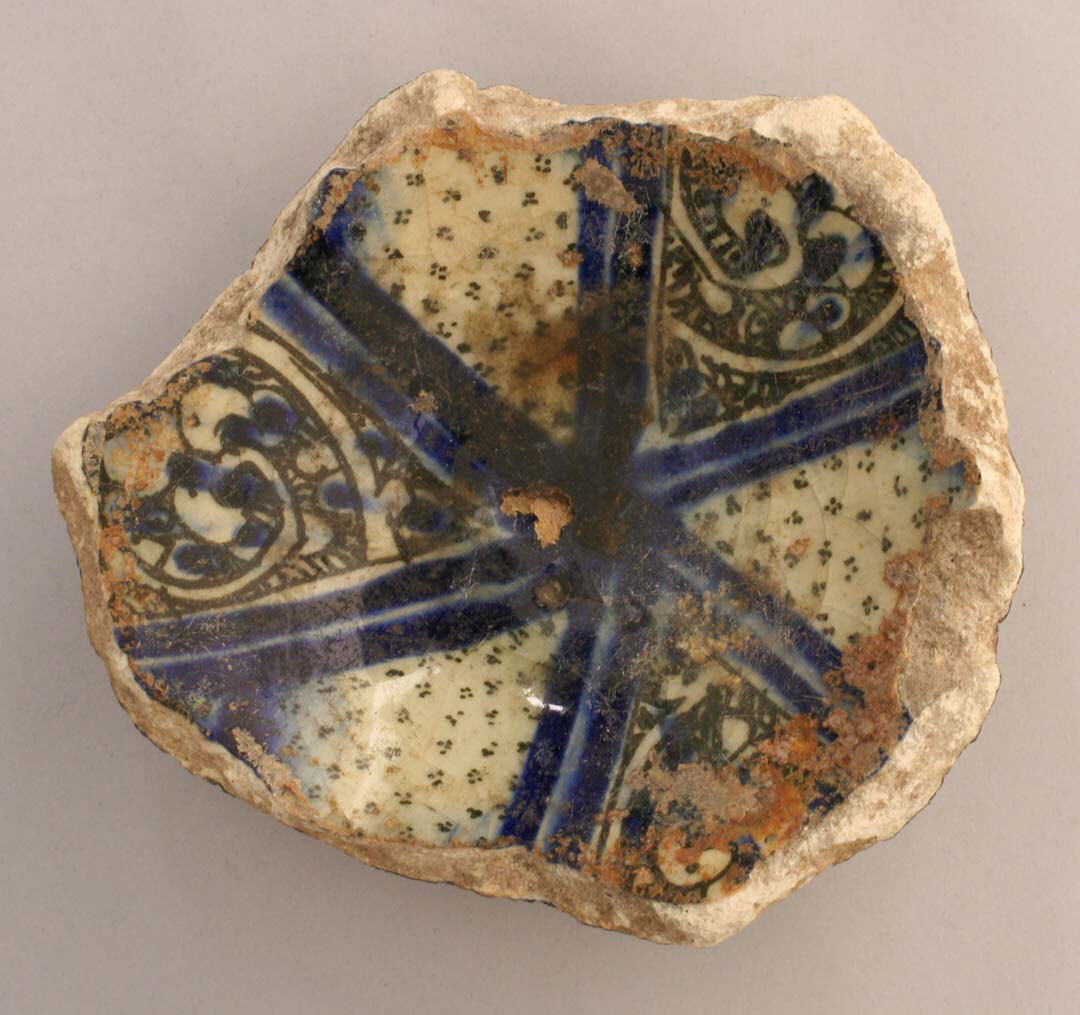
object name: fragment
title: Fragment of a Bowl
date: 1301-1400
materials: glaze, stonepaste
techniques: painting, polychrome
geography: syria